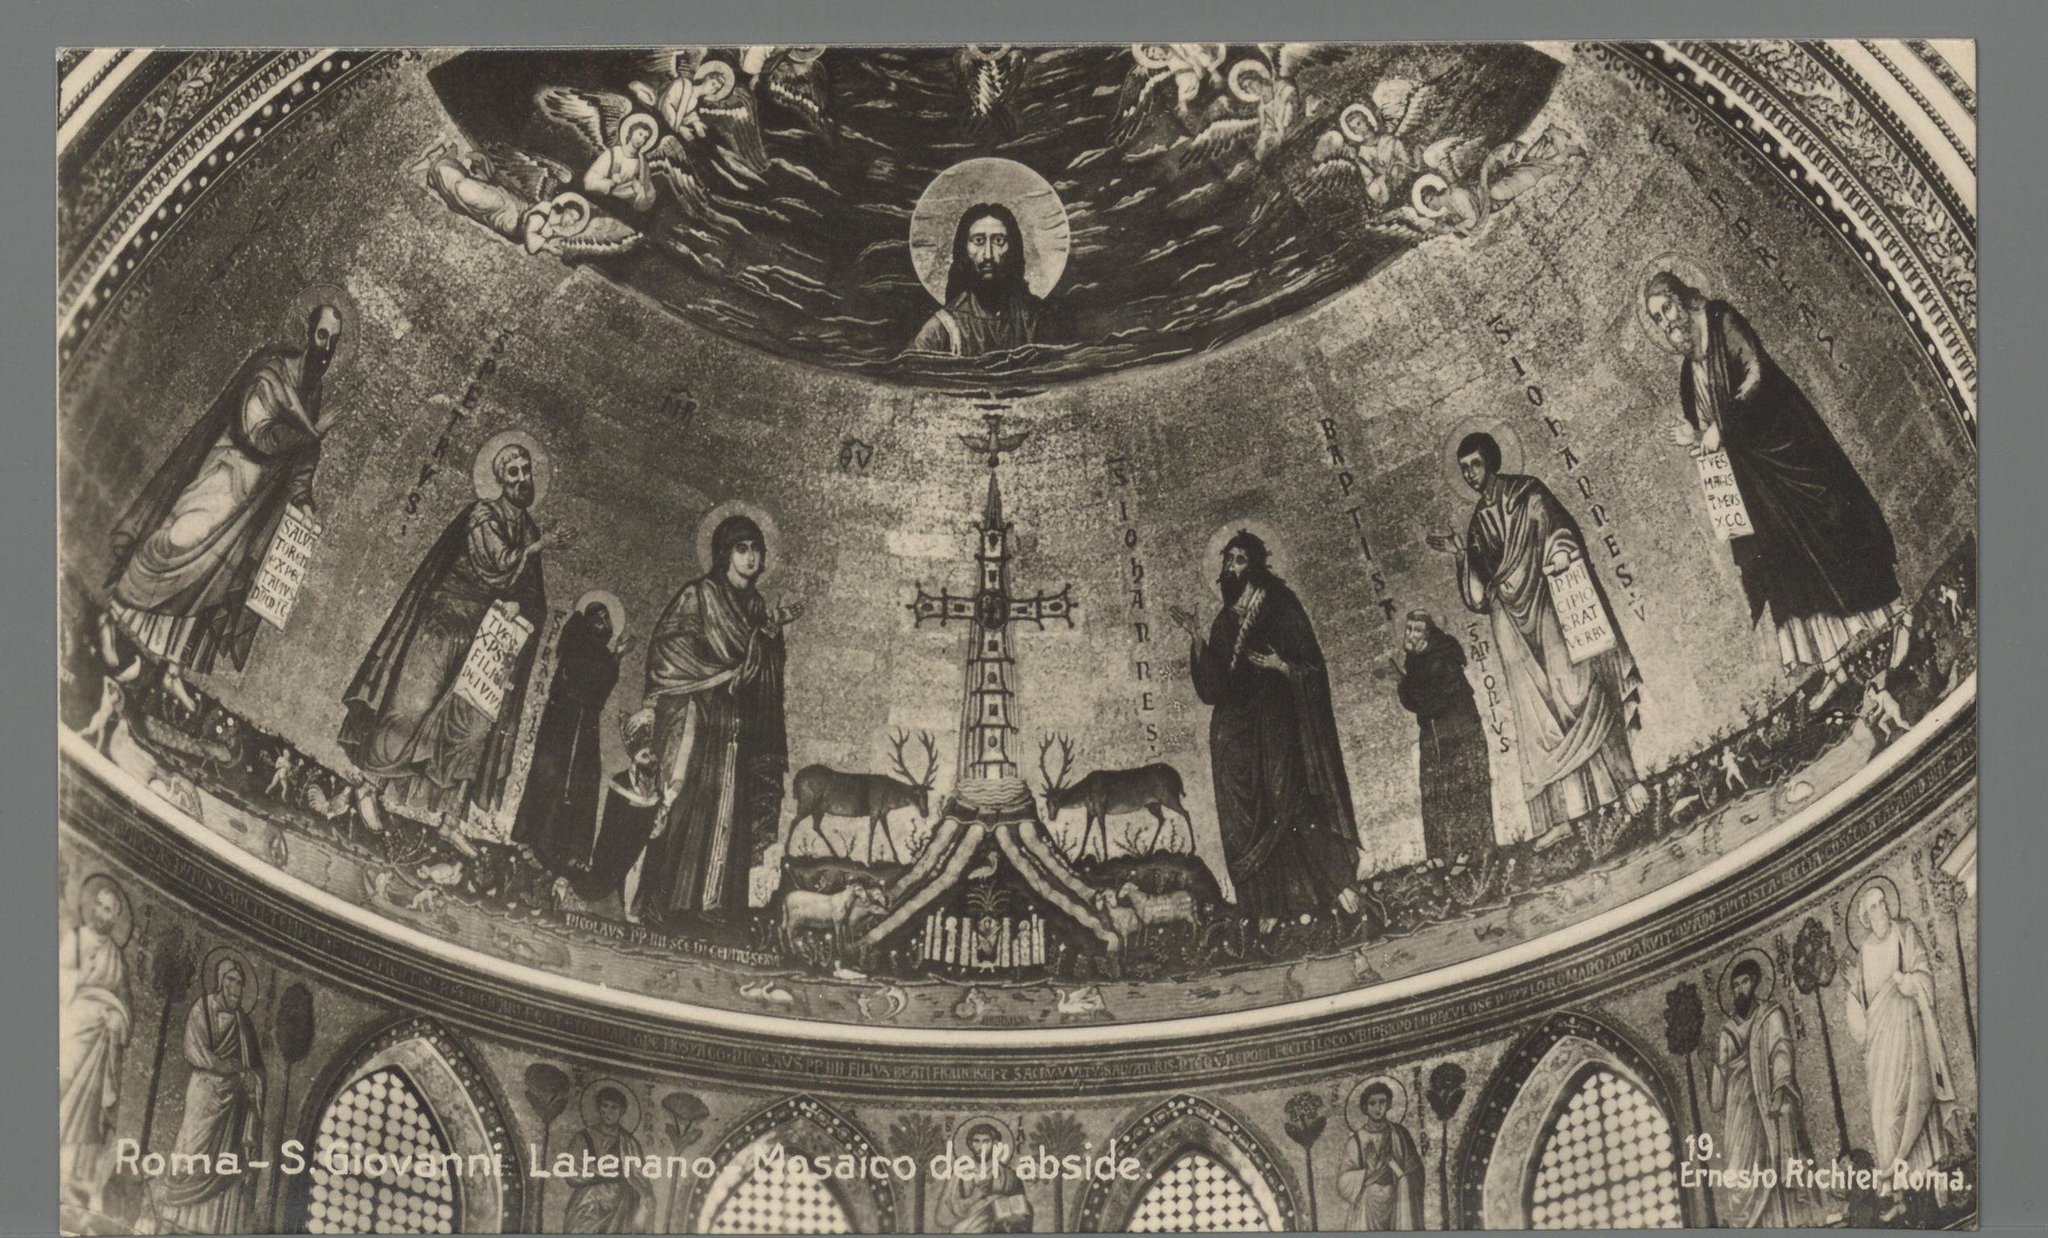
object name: ansichtkaart, prentbriefkaart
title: Roma - S. Giovanni Laterano - Mosaico dell'abside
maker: ernesto richter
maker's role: publisher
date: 1906-1930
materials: paper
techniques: gelatin silver print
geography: rome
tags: interior of church, (decorated) ceiling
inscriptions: collector's mark: ‘AFE v S’